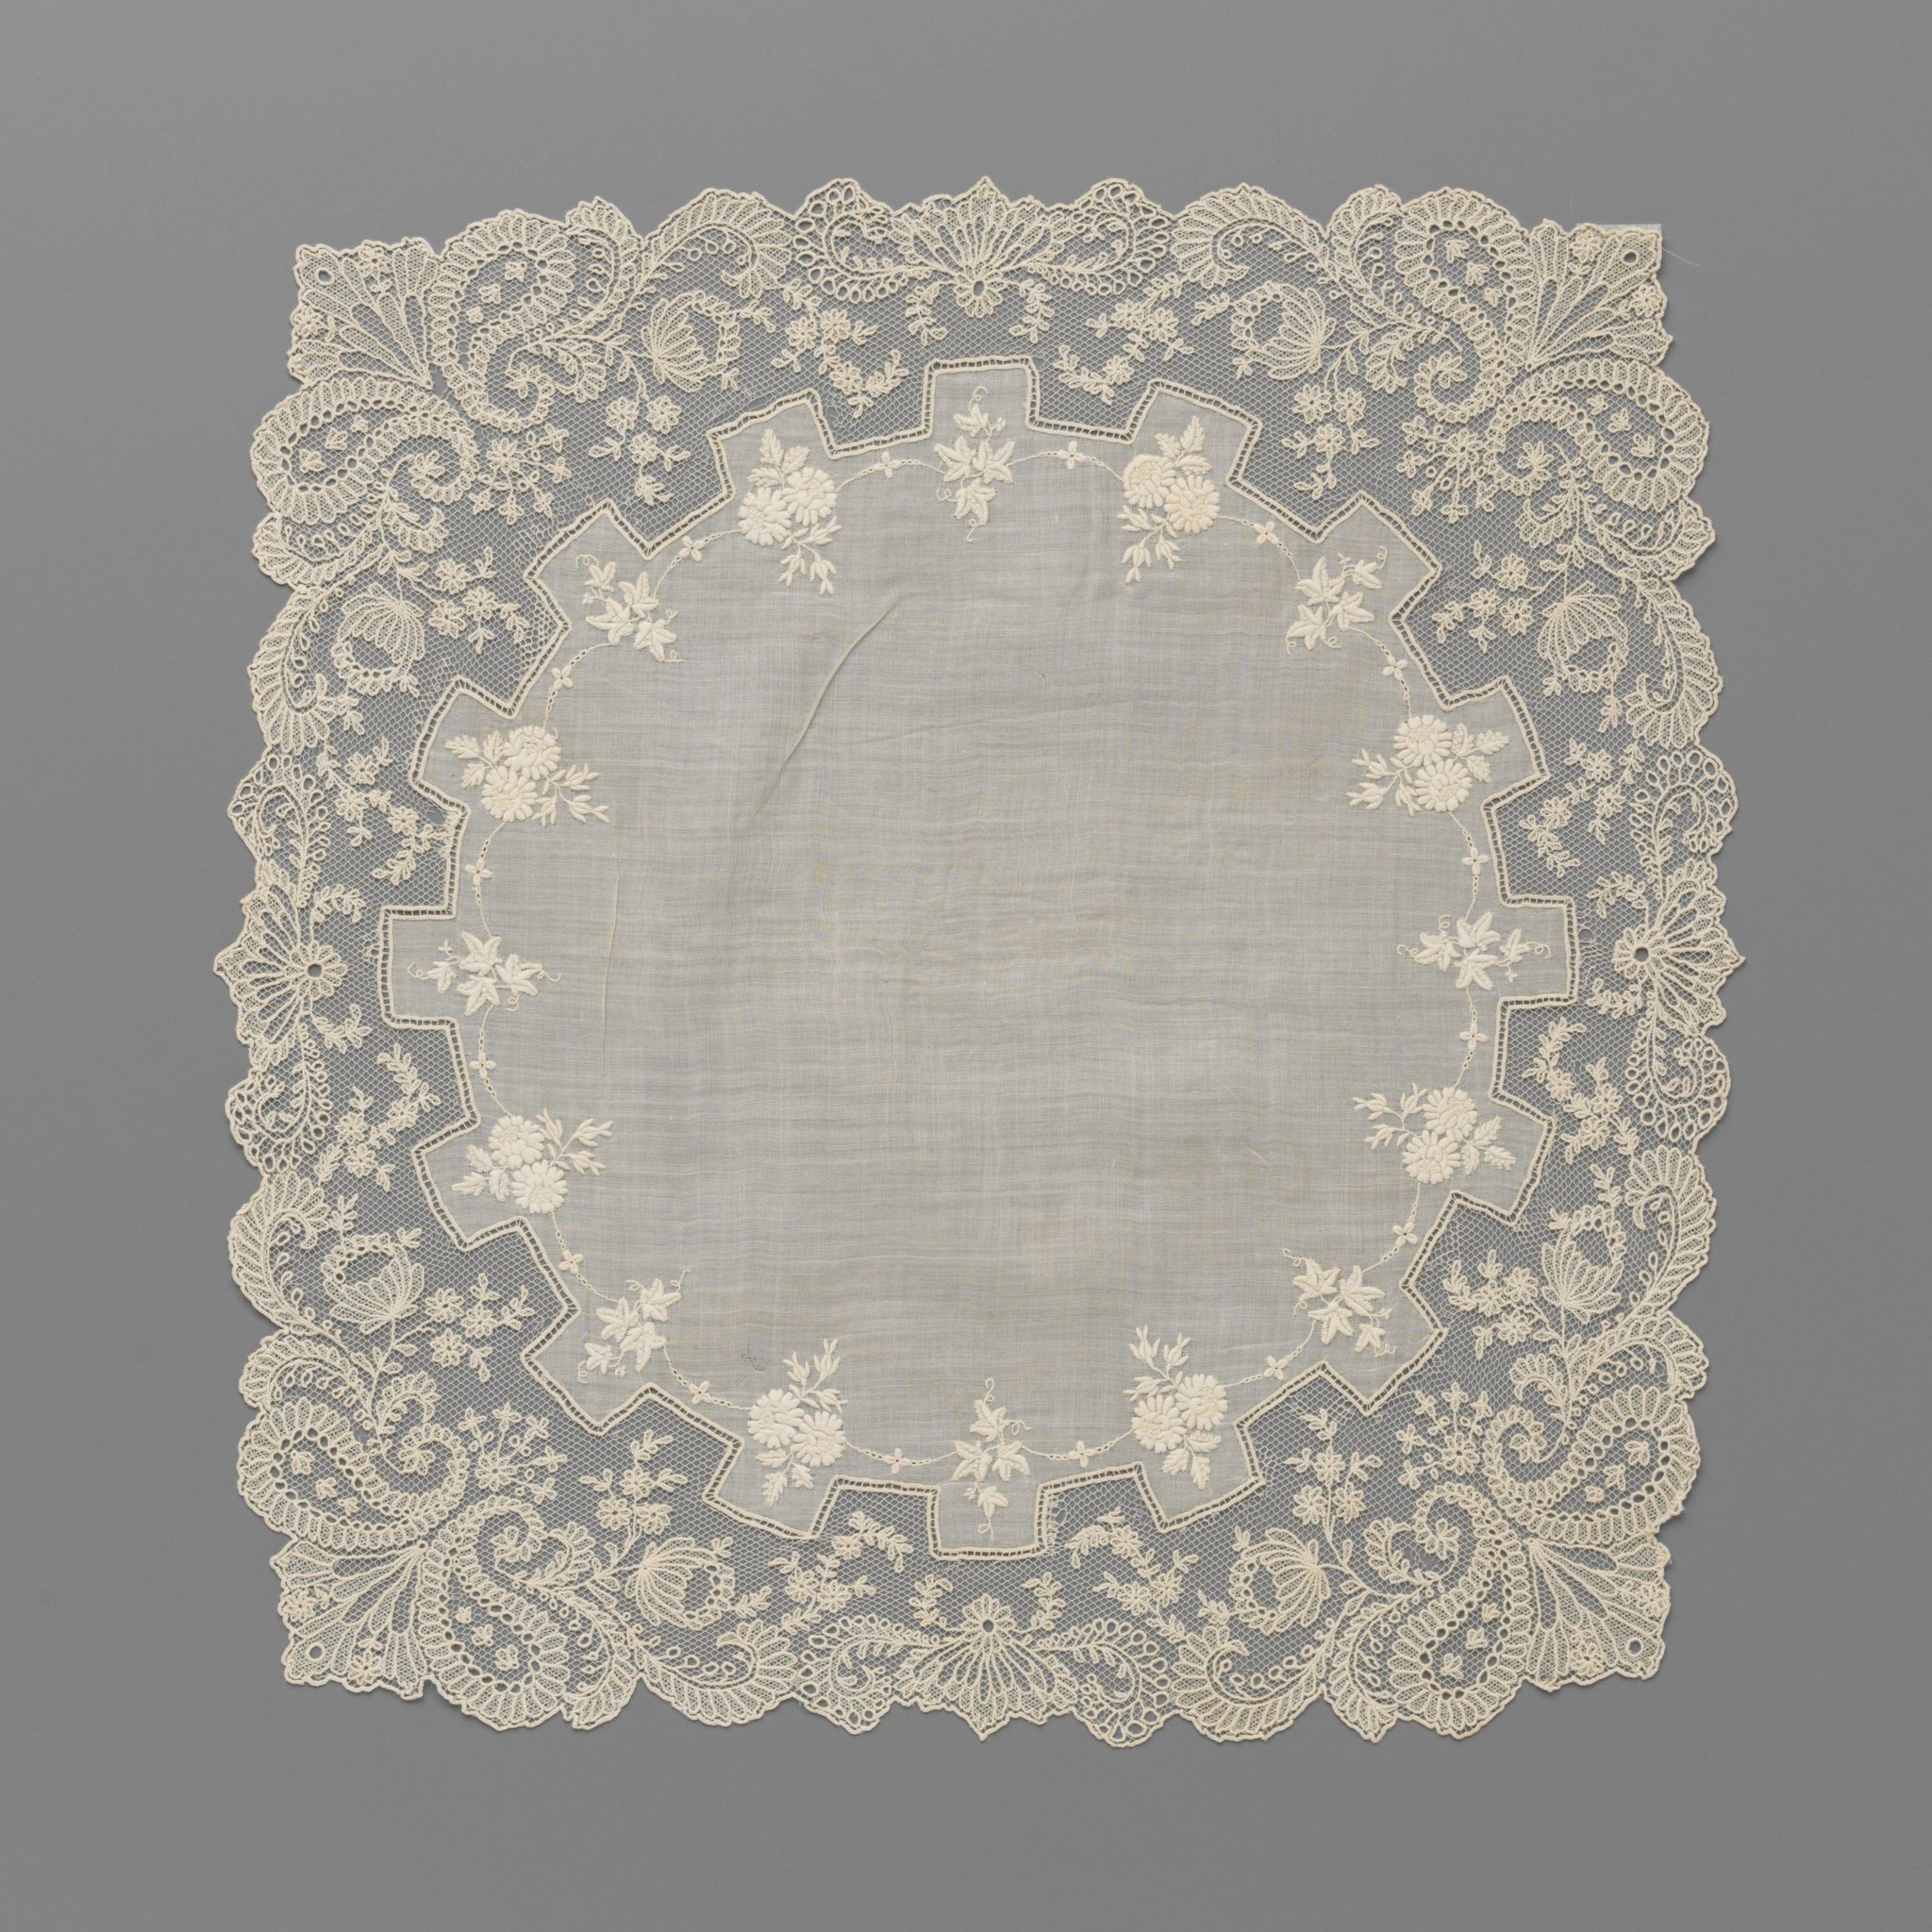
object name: handkerchief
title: Zakdoek van batist met een rand doorstop en borduurwerk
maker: mevrouw de lange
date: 1860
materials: linen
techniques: embroidered, weave, embroidery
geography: netherlands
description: Zakdoek van batist met borduurwerk - witwerk - en rondom een brede rand kantborduurwerk: tuledoorstopwerk. Vierkant model met rond middenstuk van batist. Aan het batist zijn zestien rechthoekige schulpen geknipt, die zijn afgewerkt met een smal opengewerkt randje van werk met uitgetrokken draden. Het batist is langs de rand en uitlopend in de rechthoekige schulpen geborduurd met een bloemtak met twee grote ronde bloemen en fijnere kelkbloempjes of rozenbottels afgewisseld door een viertal wingerdbladeren in de daarop volgende schulp. De bloemtakken en wingerdbladeren zijn steeds met een ijle slinger met één boogje en één vergeet-mij-nietje met elkaar verbonden. Het kantpatroon is langs elke zijde gelijk en symmetrisch. De machinale tule is op elke hoek doorgestopt met een symmetrisch palmetmotief tussen twee grote druppelvormige bladeren. Aan beide zijden wordt dit motief geflankeerd door een grote bloem, mogelijk een pioenroos, tussen enkele grote omkrullende bladeren. In het midden van elke zijde, langs de buitenrand, staat een kleiner palmetmotief tussen omkrullende bladeren. De schulpenrand langs de buitenzijde van het machinale tule komt voort uit het patroon met de palmetten en omkrullende bladeren.